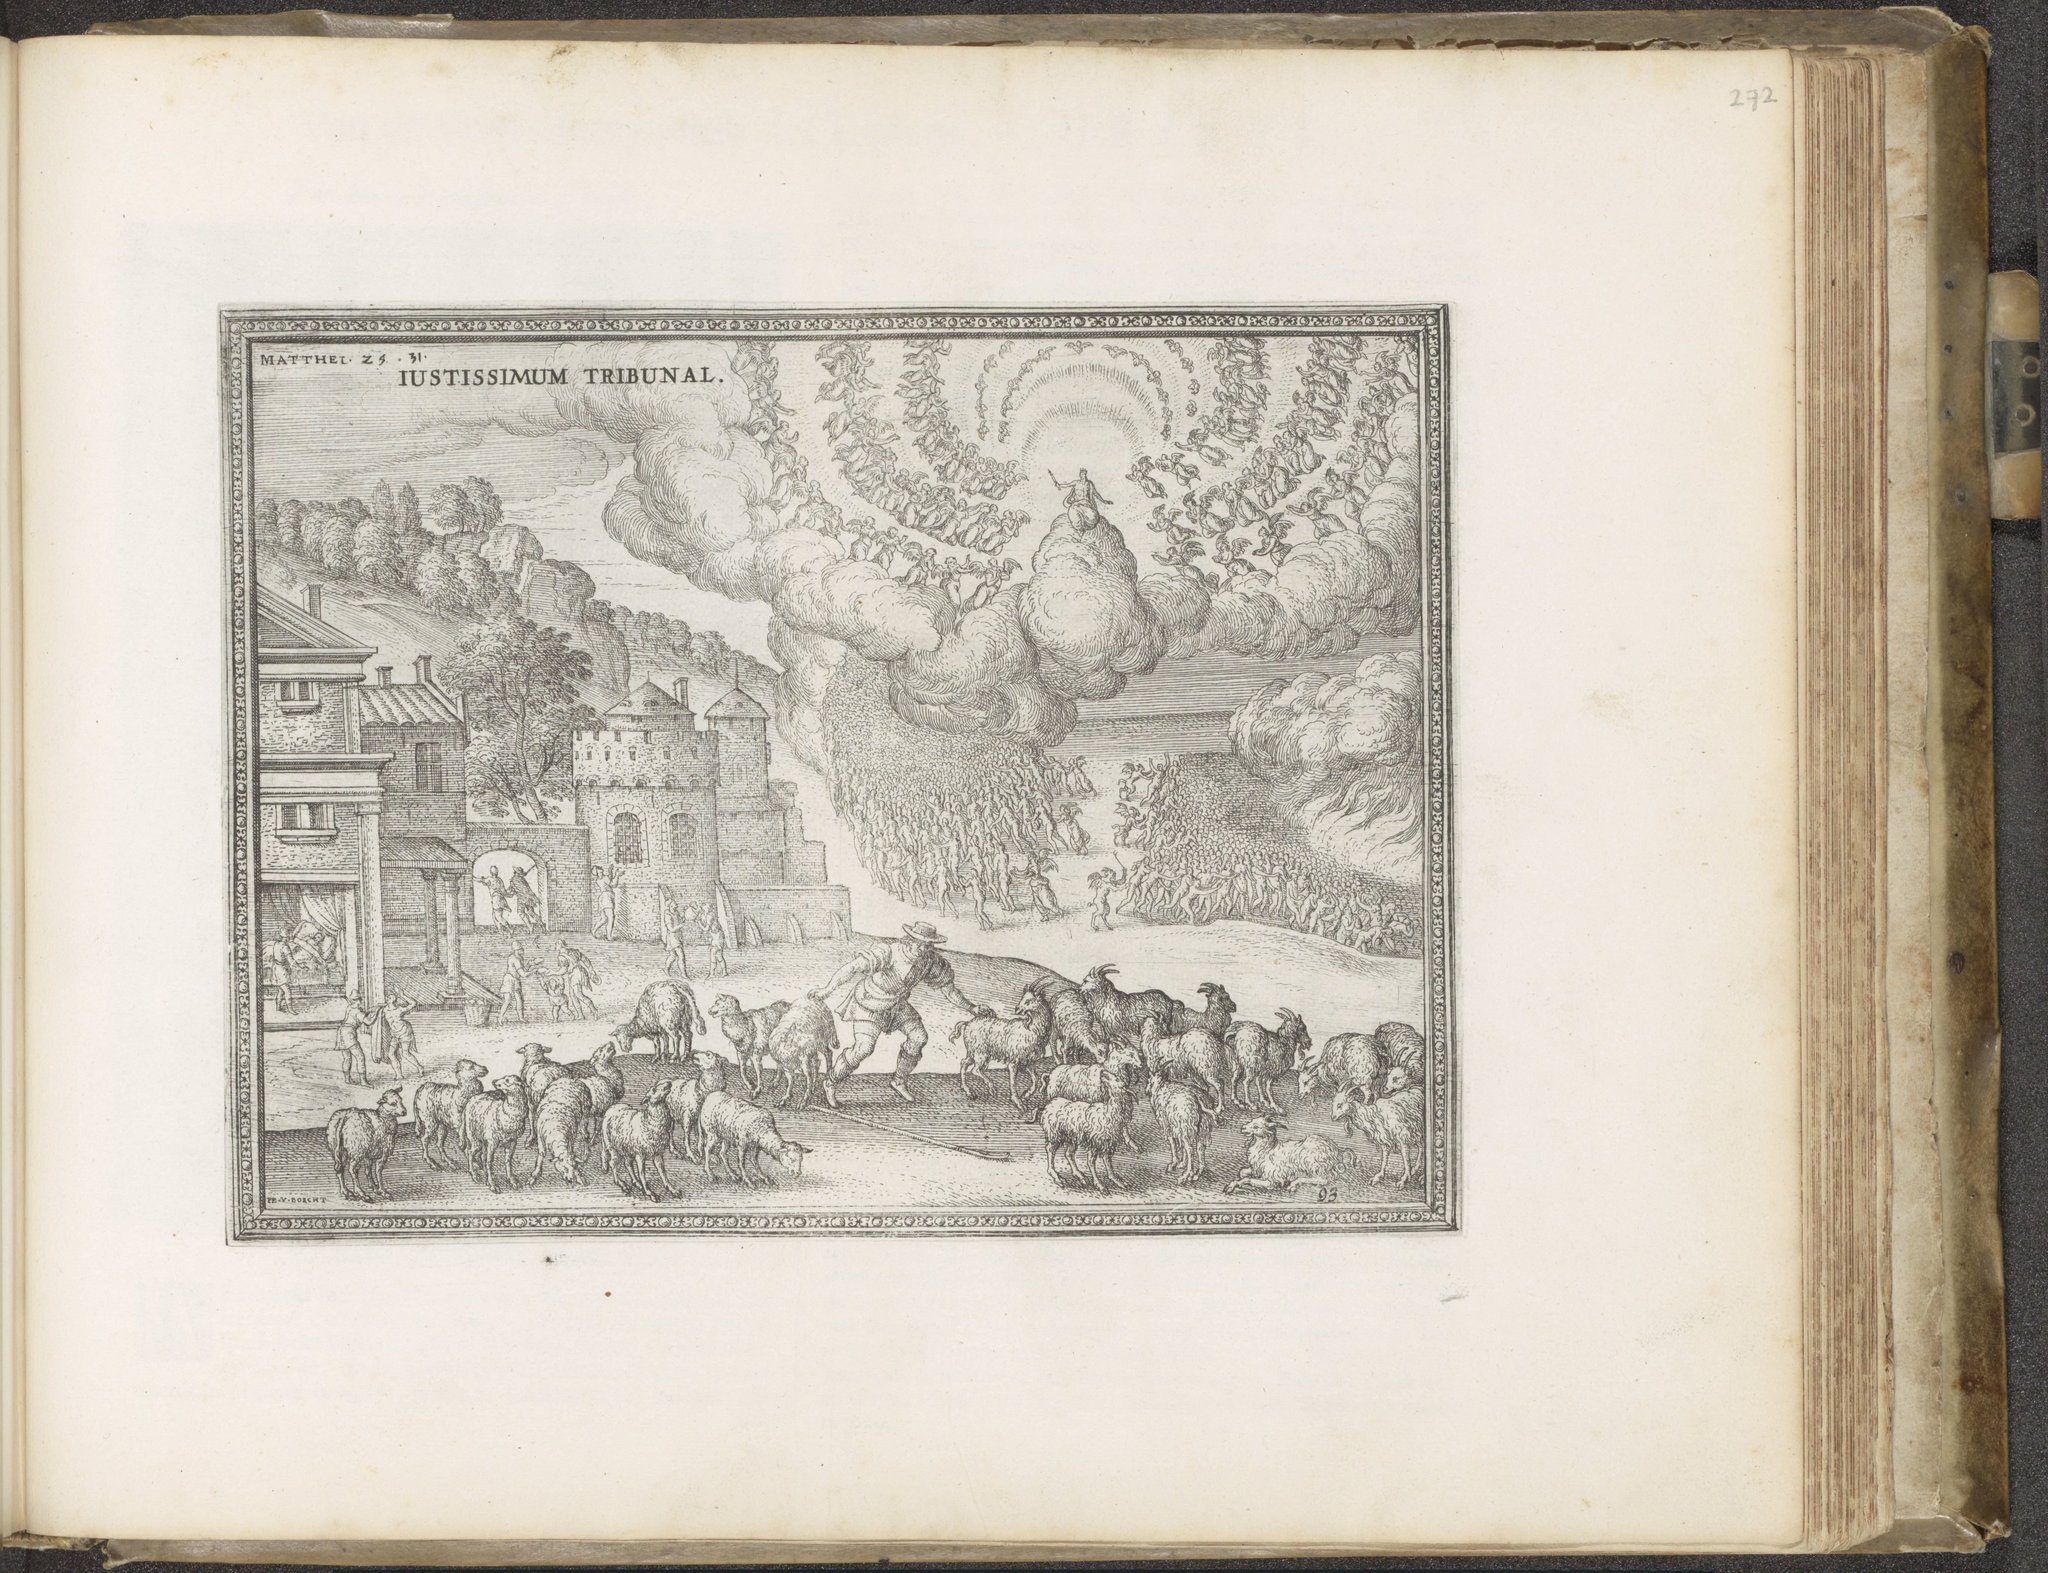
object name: print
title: Den Grooten Emblemata Sacra, bestaande in meer dan vier hondert bybelsche figuren, zoo des Ouden als des Nieuwen Testaments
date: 1582-1593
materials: paper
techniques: etching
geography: amsterdam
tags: 'as a shepherd (the son of man) separates the sheep from the goats' (matthew 25:32), representation of last judgement, with the archangel michael weighing the souls (or dividing the blessed and the damned)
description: Een herder scheidt de schapen van de bokken. Links op de achtergrond enkele gebouwen met een poort. Christus troont op de wolken en velt het laatste oordeel. De doden worden door engelen naar de hemel geleid of naar de hel gevoerd (Mat. 25). De prent maakt deel uit van een album.